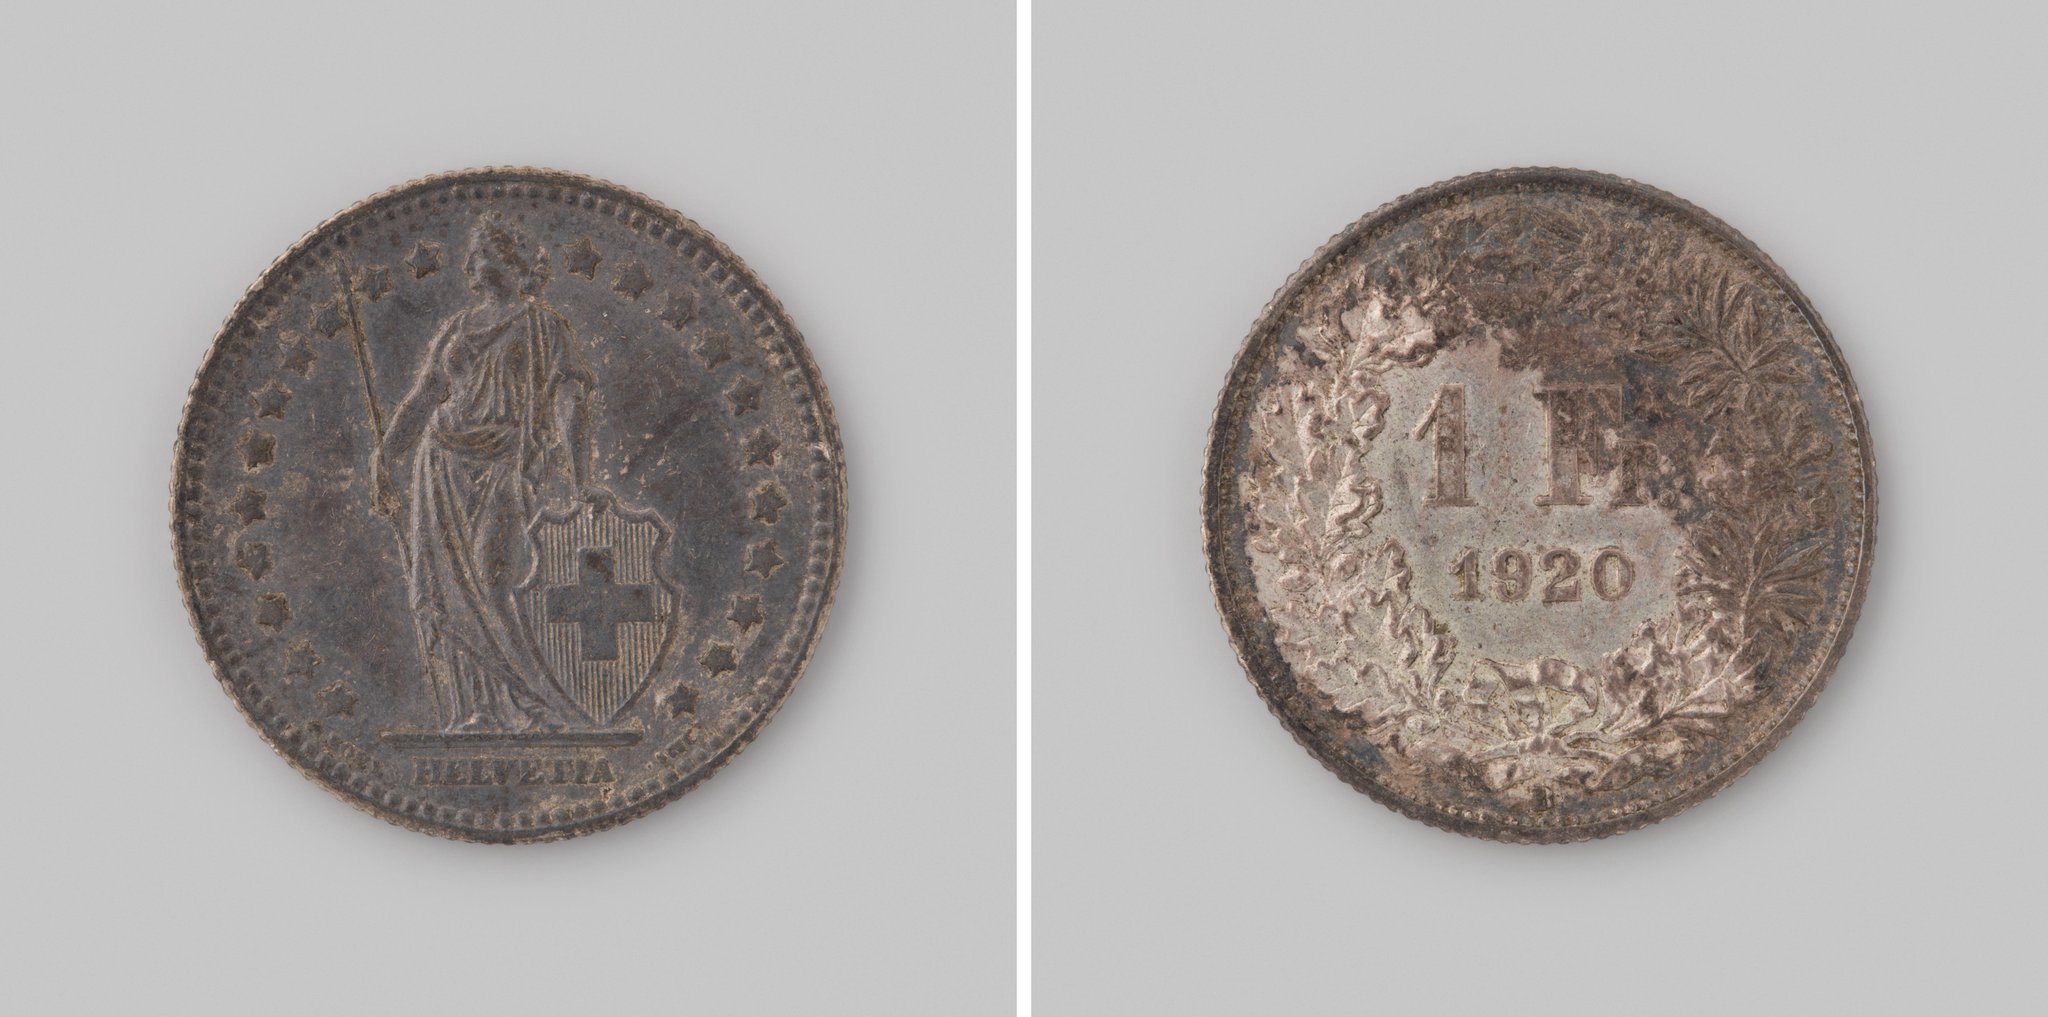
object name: coin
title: Frank uit Zwitserland, 1920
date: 1920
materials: silver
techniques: striking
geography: bern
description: Zilveren munt. Voorzijde: Binnen een ring van sterren staande Helvetia met het wapenschild van Zwitserland. Keerzijde: binnen twee samengebonden takken in een regel waarde-aanduiding: 1 Fr., waaronder jaartal. Onderaan letter B [=Bern]. Kartelrand.